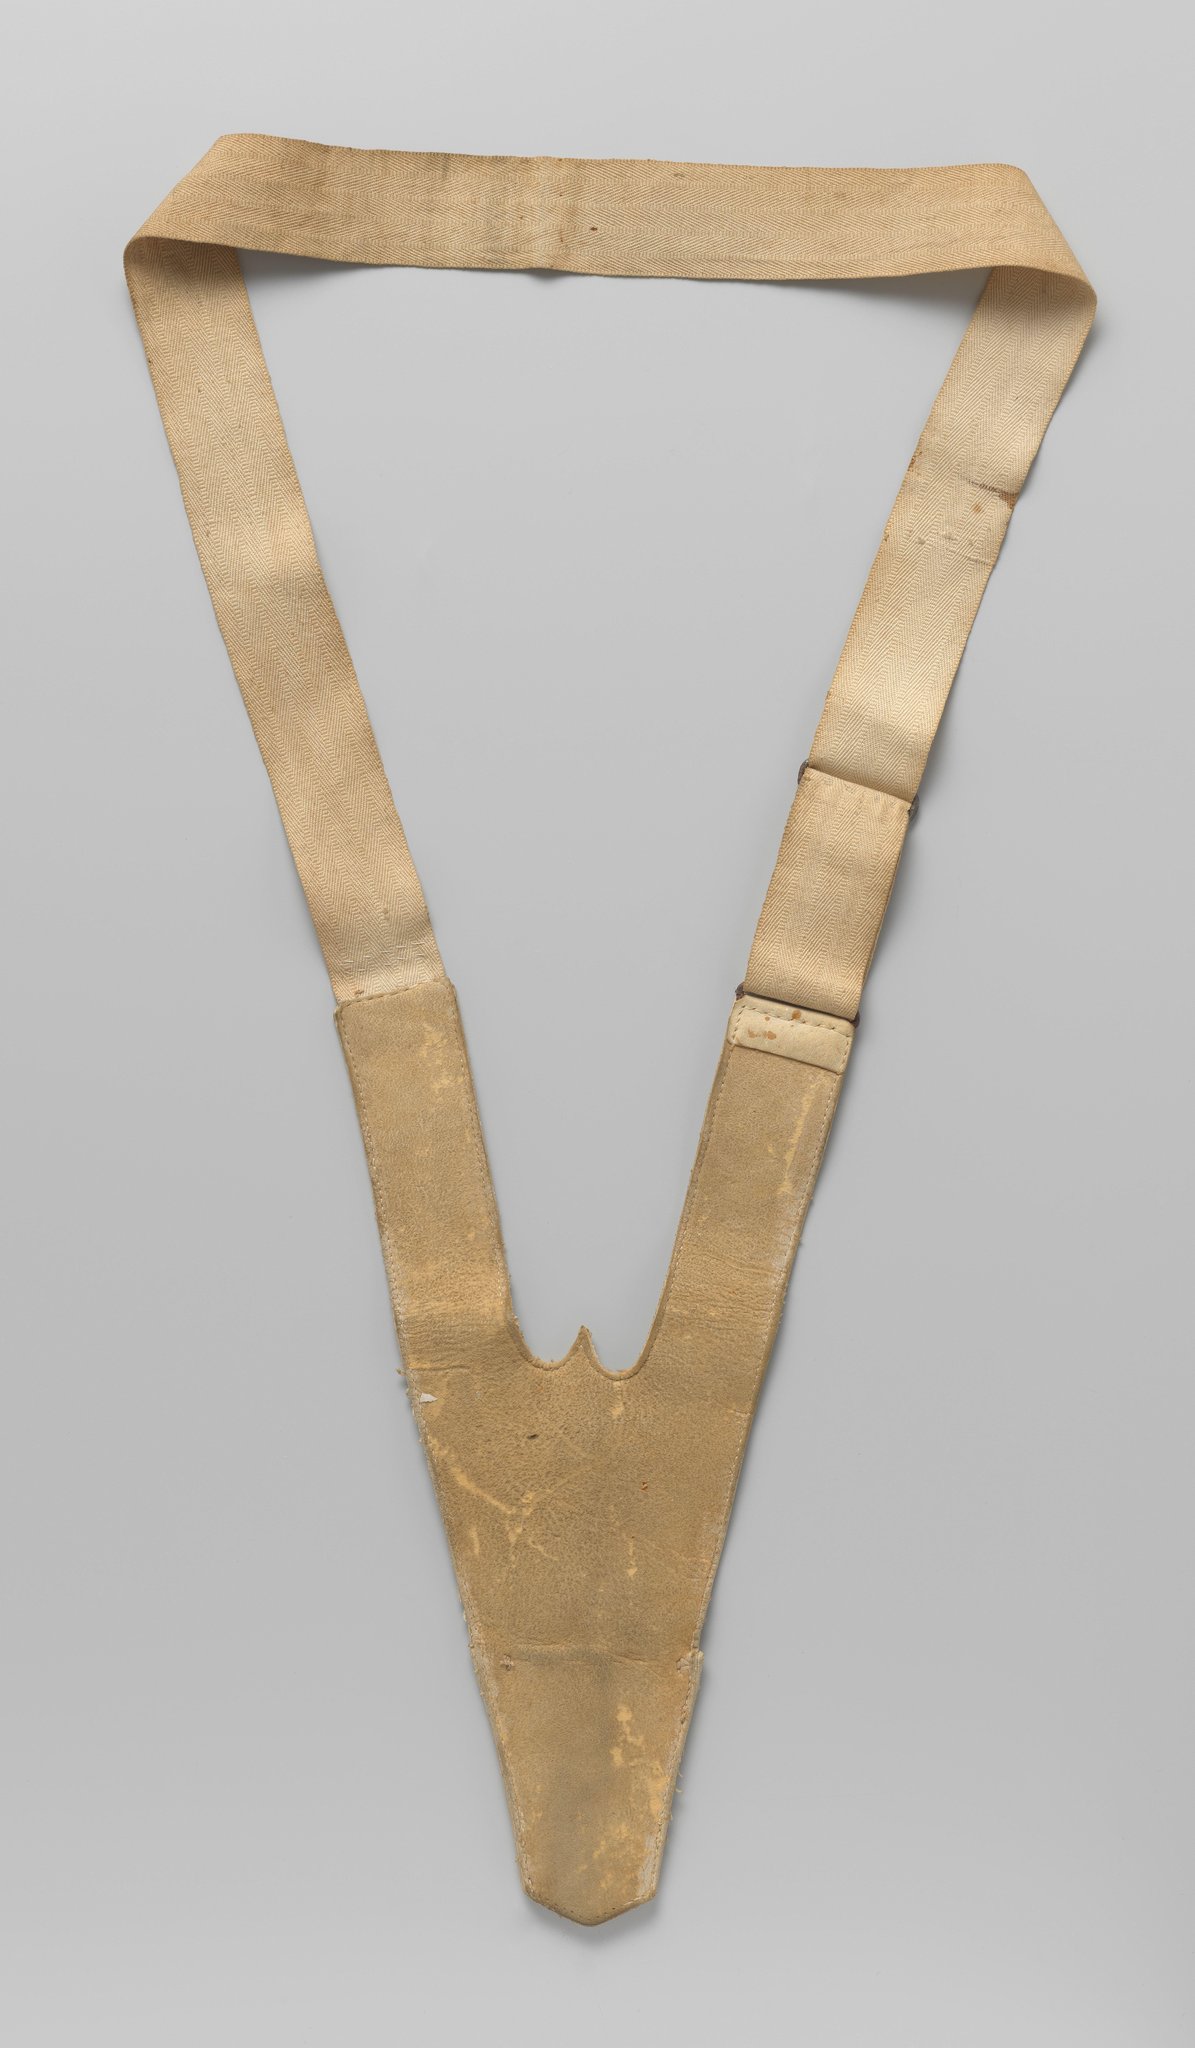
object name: bandolier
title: Degenbandelier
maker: Anonymous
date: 1800-1900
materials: leather, metal, textile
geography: europe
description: Degenbandelier van wit textiel en leer met twee gespen.